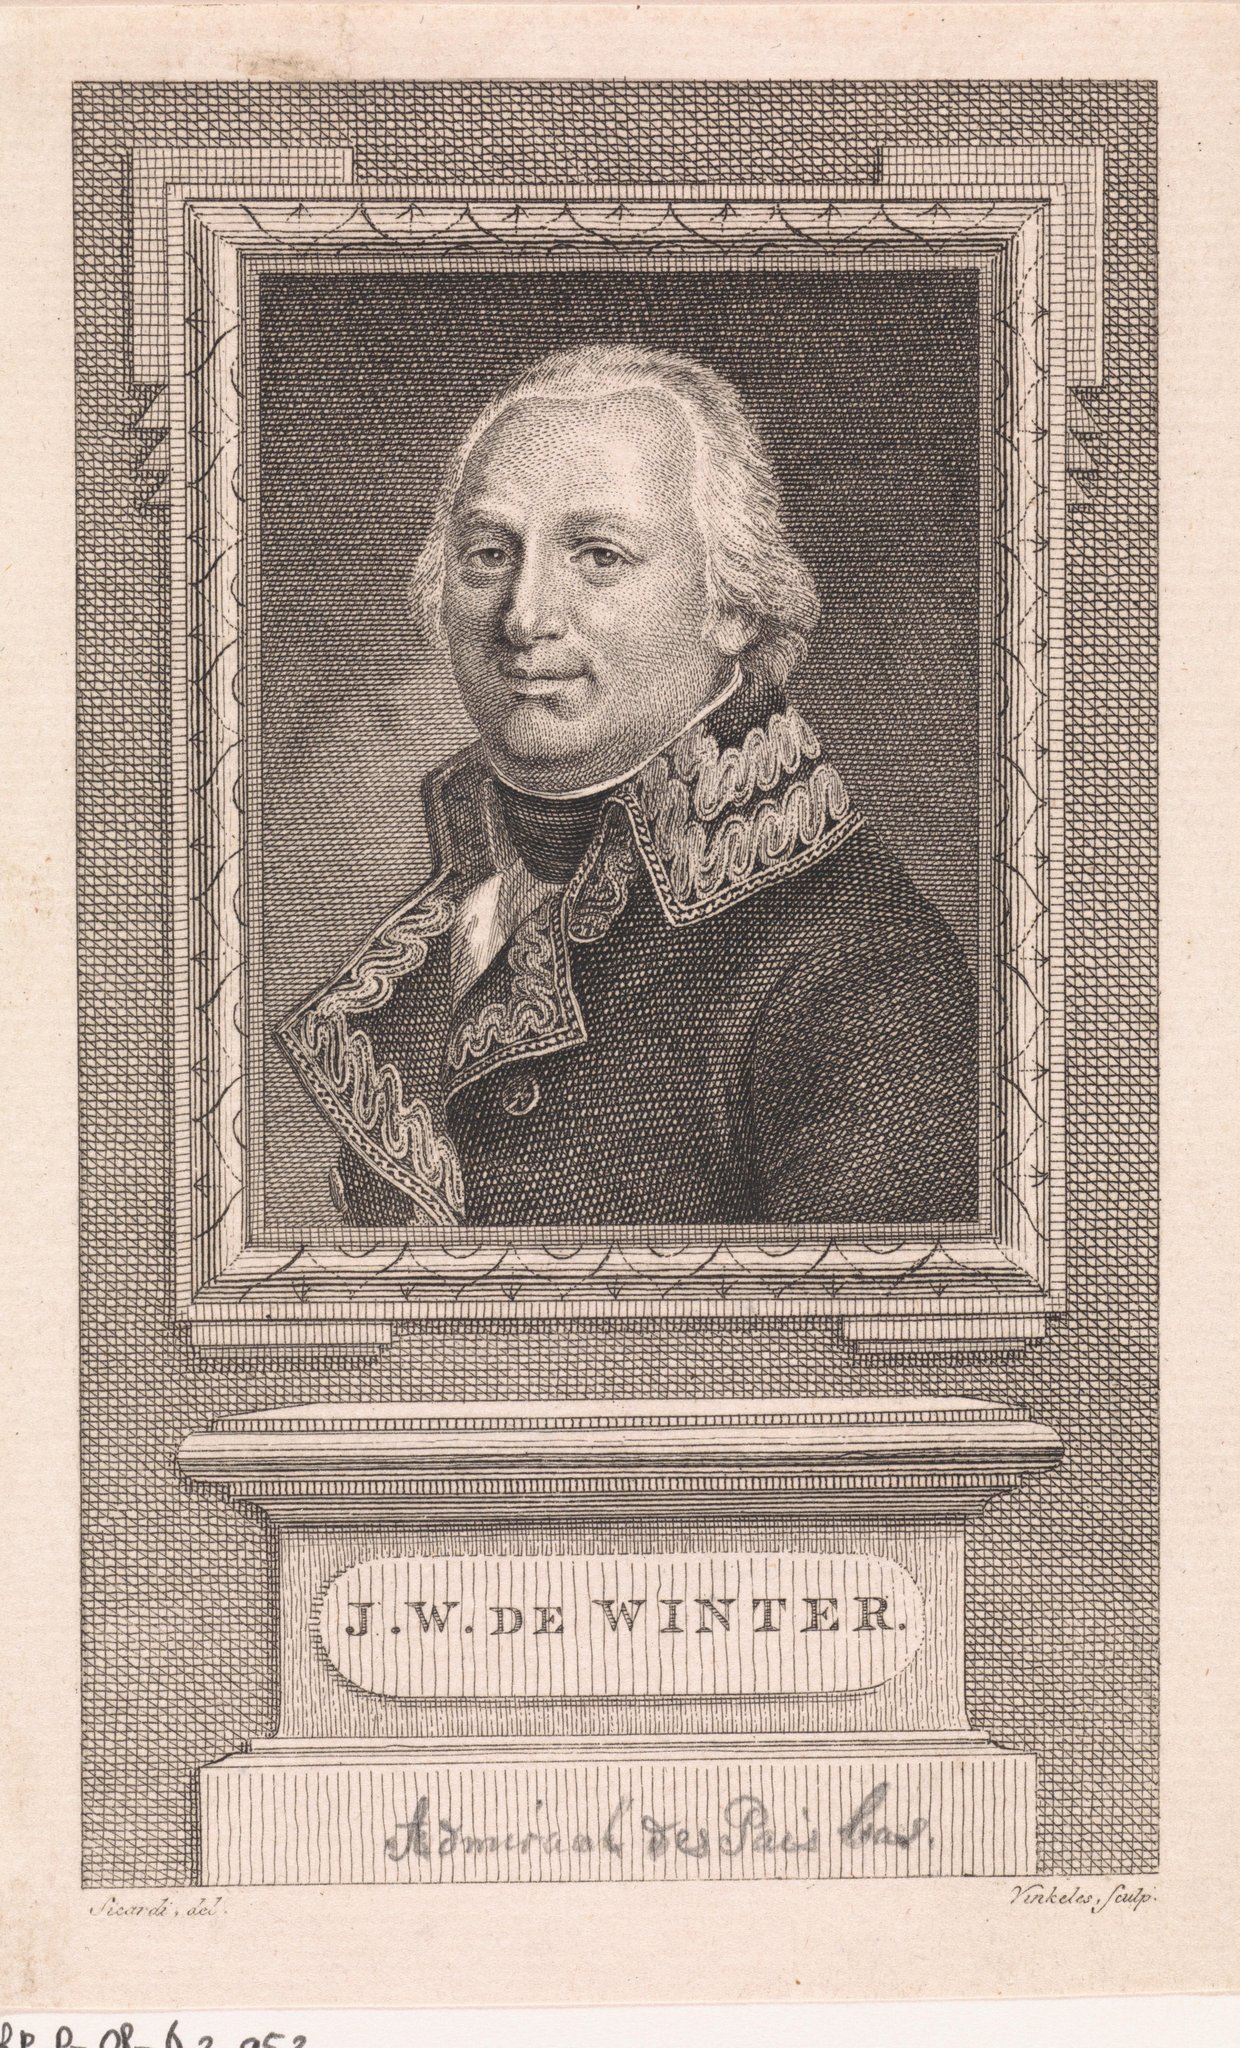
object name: print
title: Portret van Jan Willem de Winter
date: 1786-1809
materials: paper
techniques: engraving, etching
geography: amsterdam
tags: paris, jan willem de winter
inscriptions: collector's mark: Lugt 2228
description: Prent ook gebruikt als boekillustratie in: Wagenaar, Jan. Vaderlandsche historie, (...) ten vervolge van Wagenaars Vaderlandsche historie. Dl. 1-43. Amsterdam: Johannes Allart, 1786-1809.